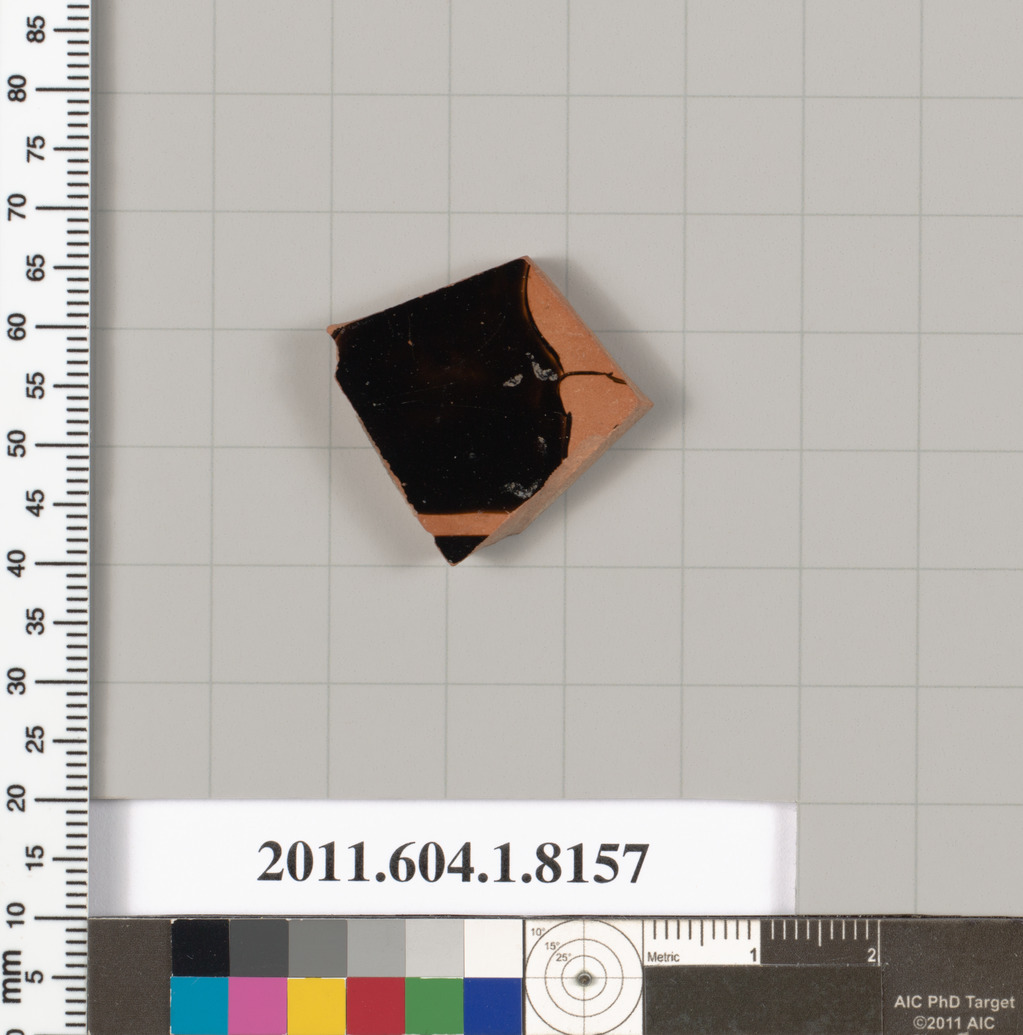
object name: kylix fragment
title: Terracotta fragment of a kylix (drinking cup)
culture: greek, attic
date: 520-500 BCE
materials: terracotta